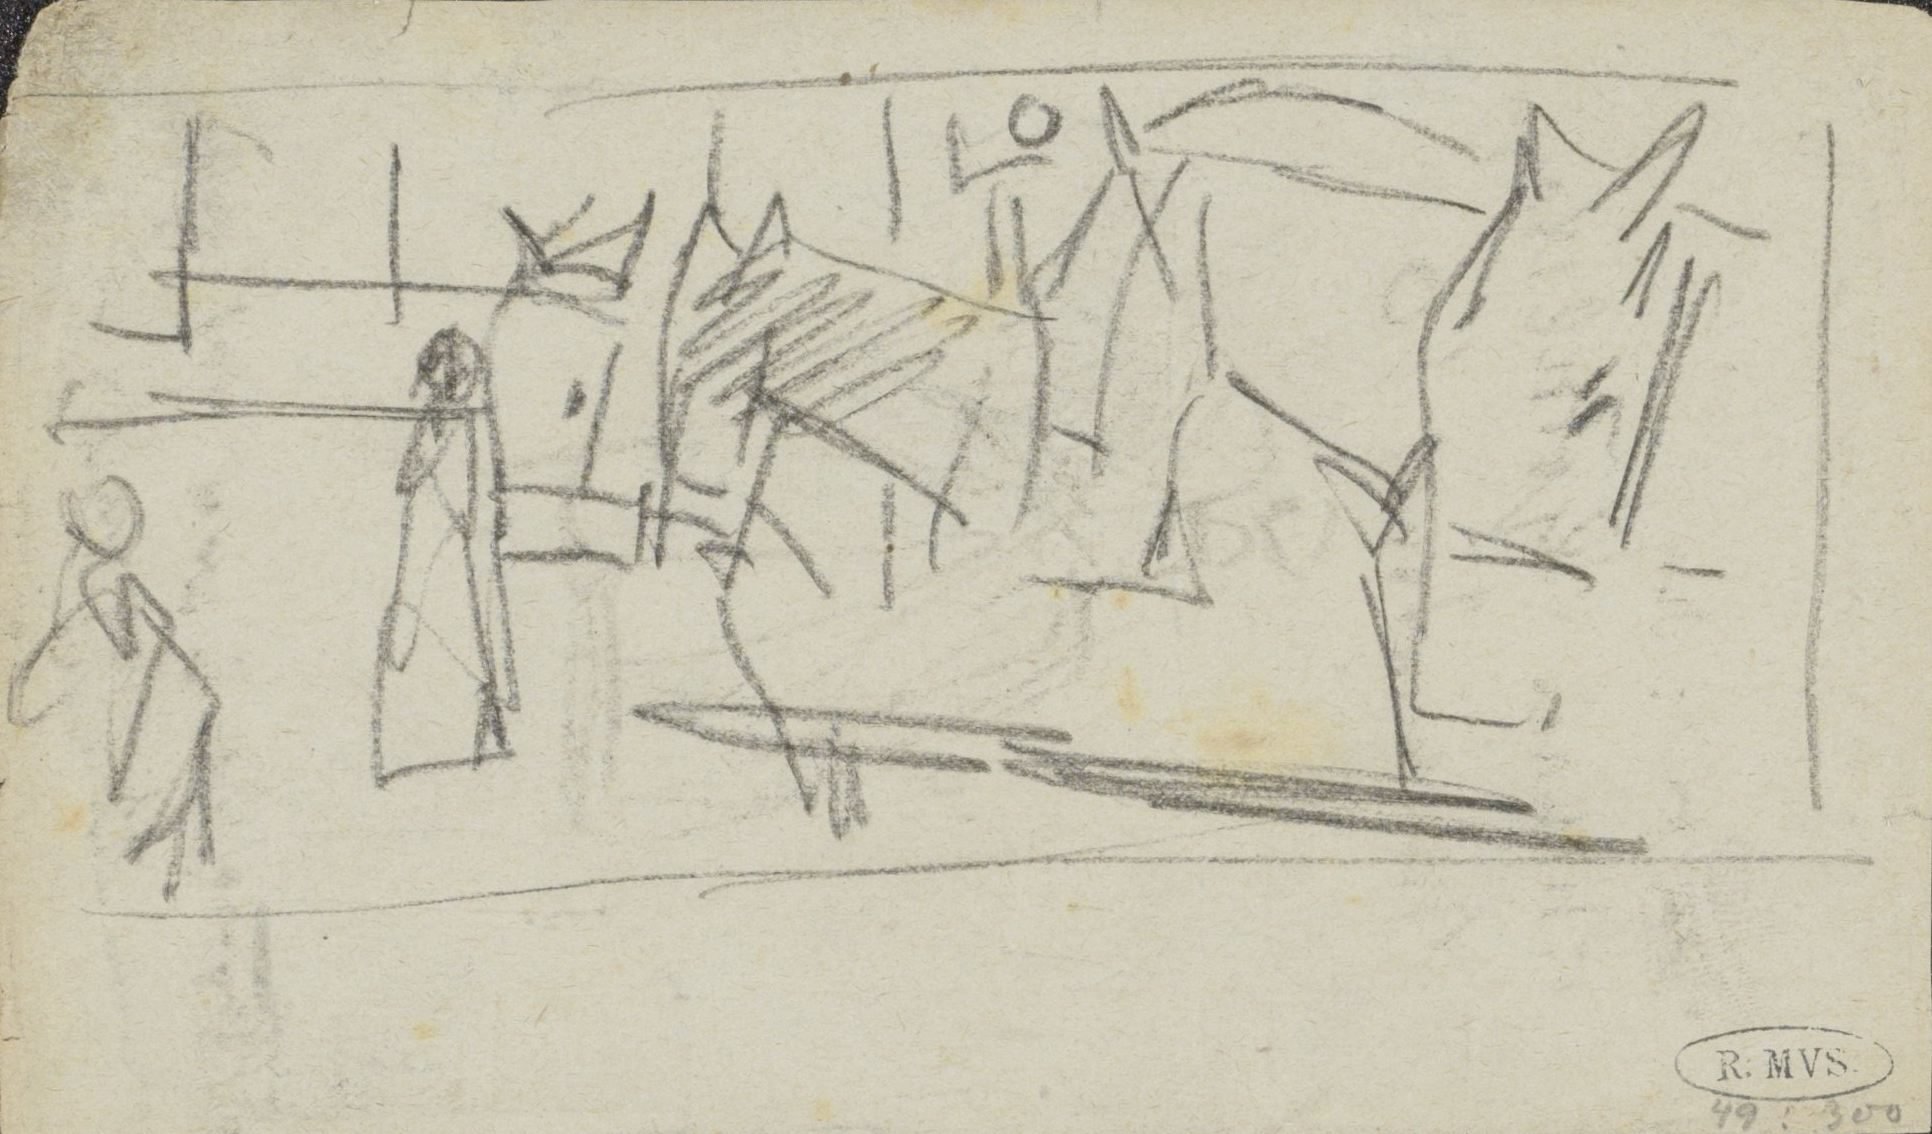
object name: drawing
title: Figuren bij trampaarden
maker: george hendrik breitner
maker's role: draughtsman, painter, print maker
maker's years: 1857-1923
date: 1886-1923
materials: chalk, paper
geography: amsterdam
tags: diligence, omnibus, horse-tram (+ man and animal)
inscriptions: collector's mark: Lugt 2228